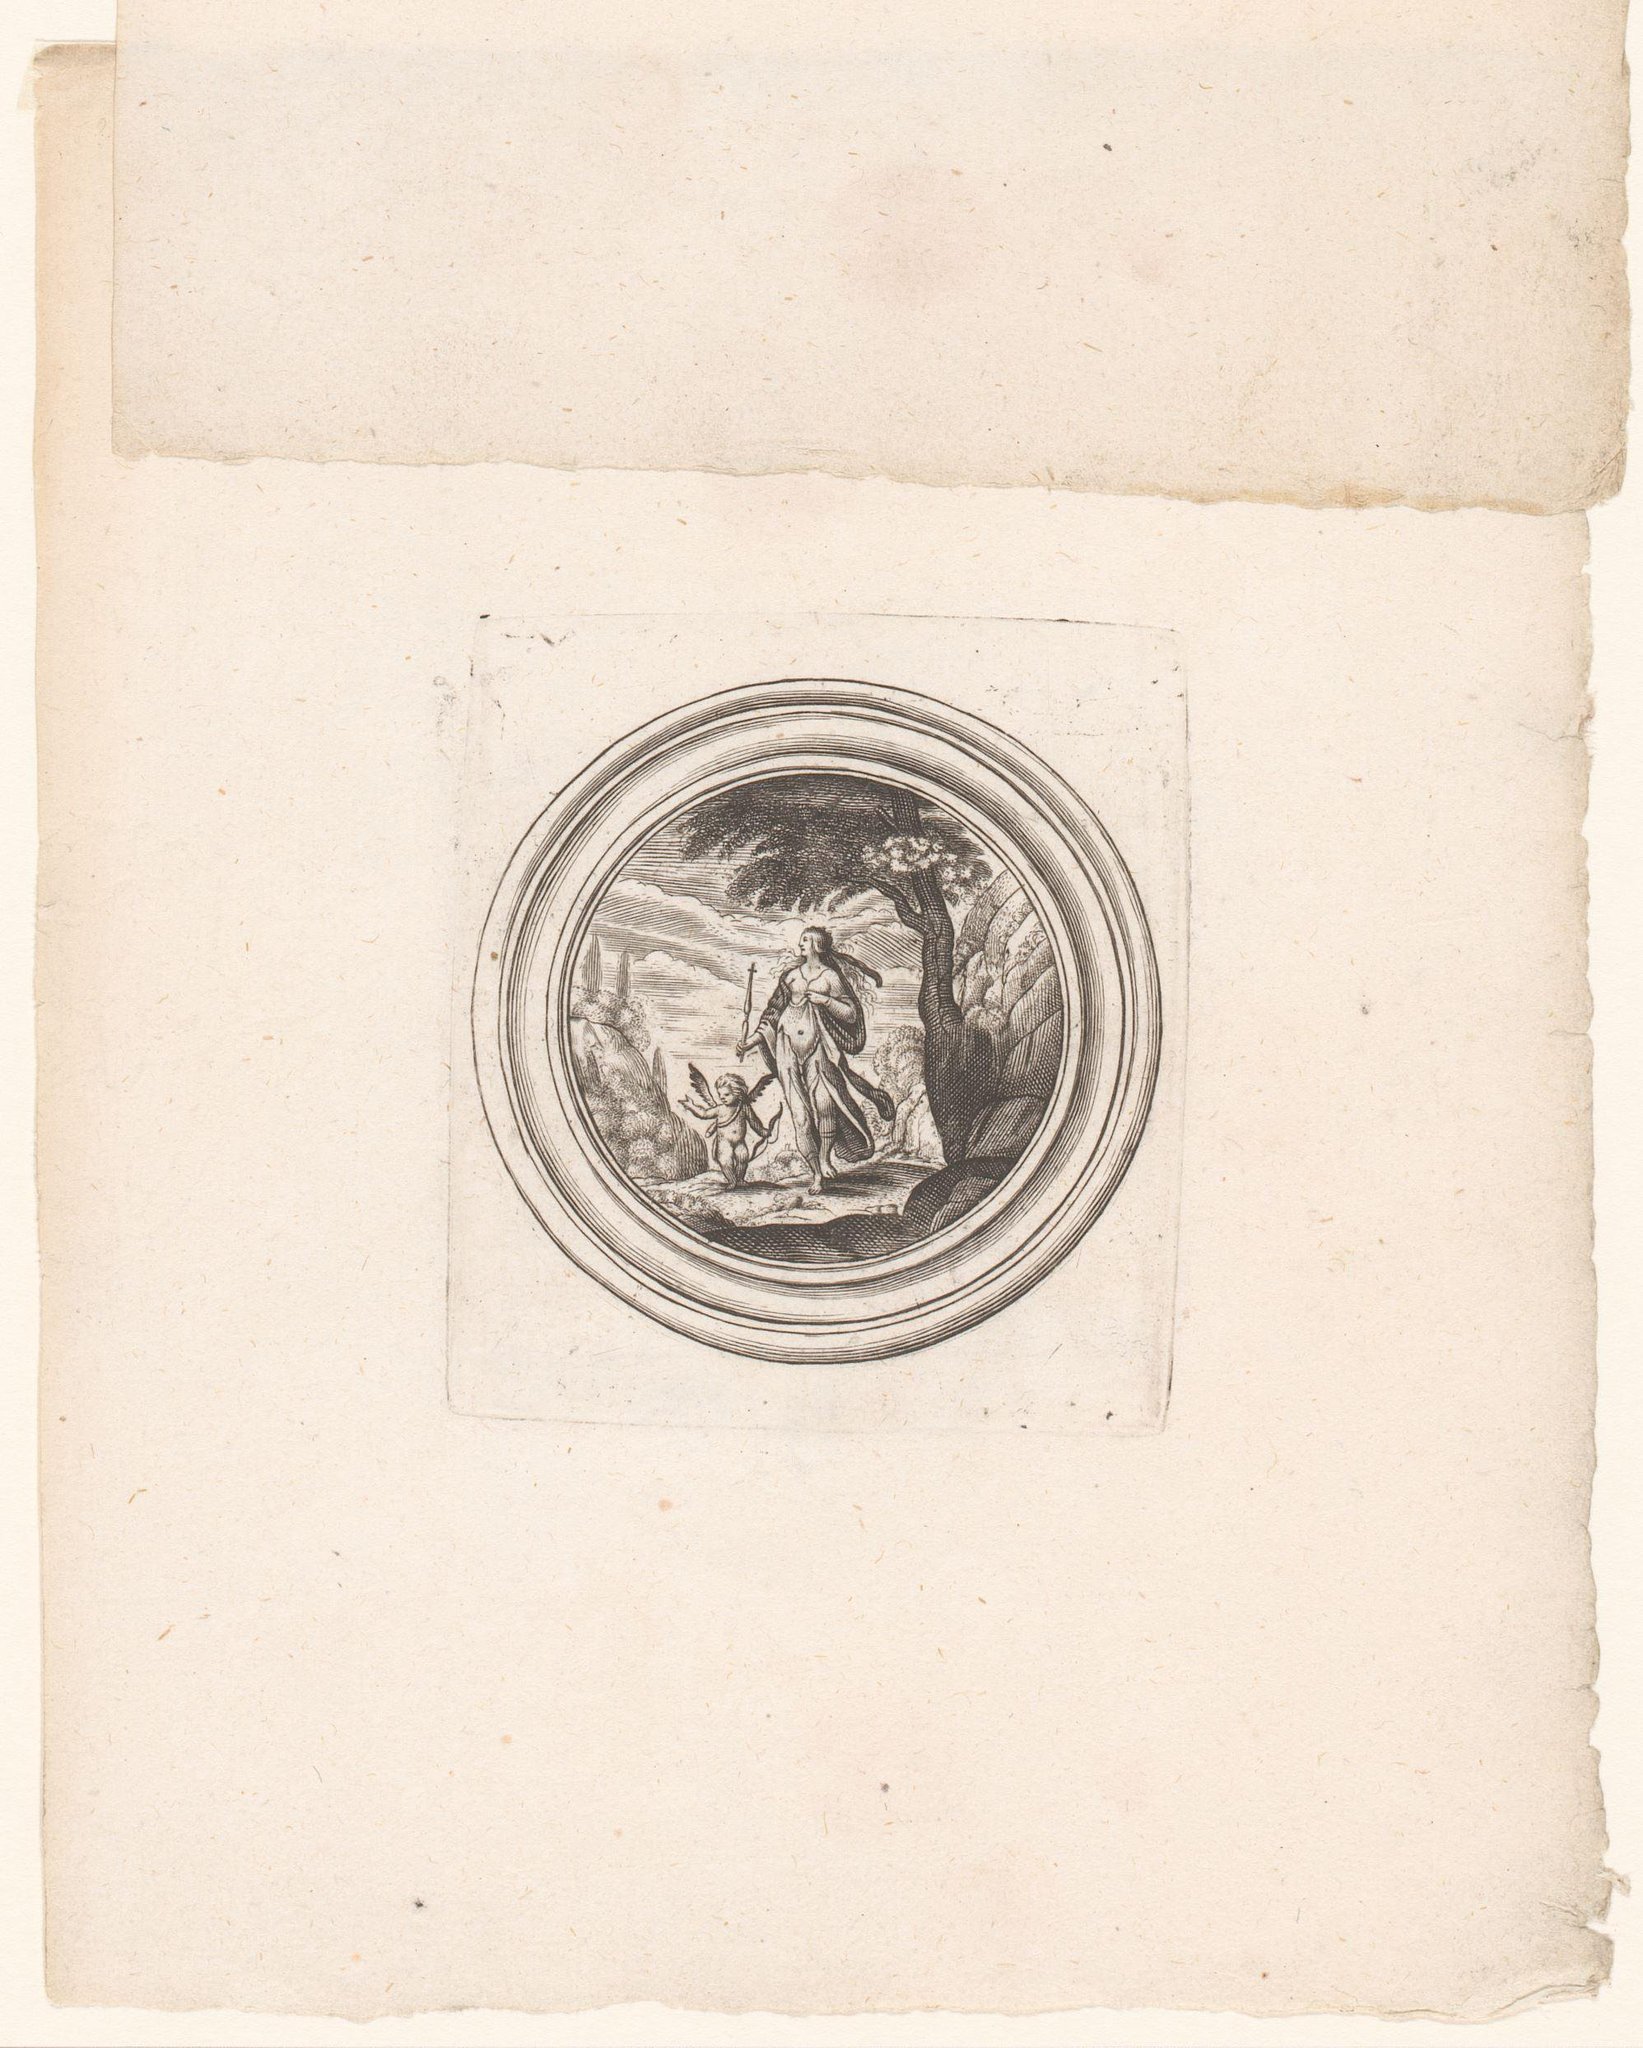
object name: print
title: Venus en Amor in een landschap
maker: Anonymous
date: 1630-1699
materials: paper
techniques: engraving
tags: (story of) cupid, amor (eros), (story of) venus (aphrodite), venus and cupid (cupid not being mere attribute)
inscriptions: collector's mark: Lugt 2228, collector's mark: Lugt 2760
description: Betreft een kopie naar een prent door Abraham Bosse die deel uitmaakt van een serie van drie prenten met de godinnen Juno, Venus en Minerva in ronde omlijstingen. De serie werd ontworpen, vervaardigd en uitgegeven door Abraham Bosse.